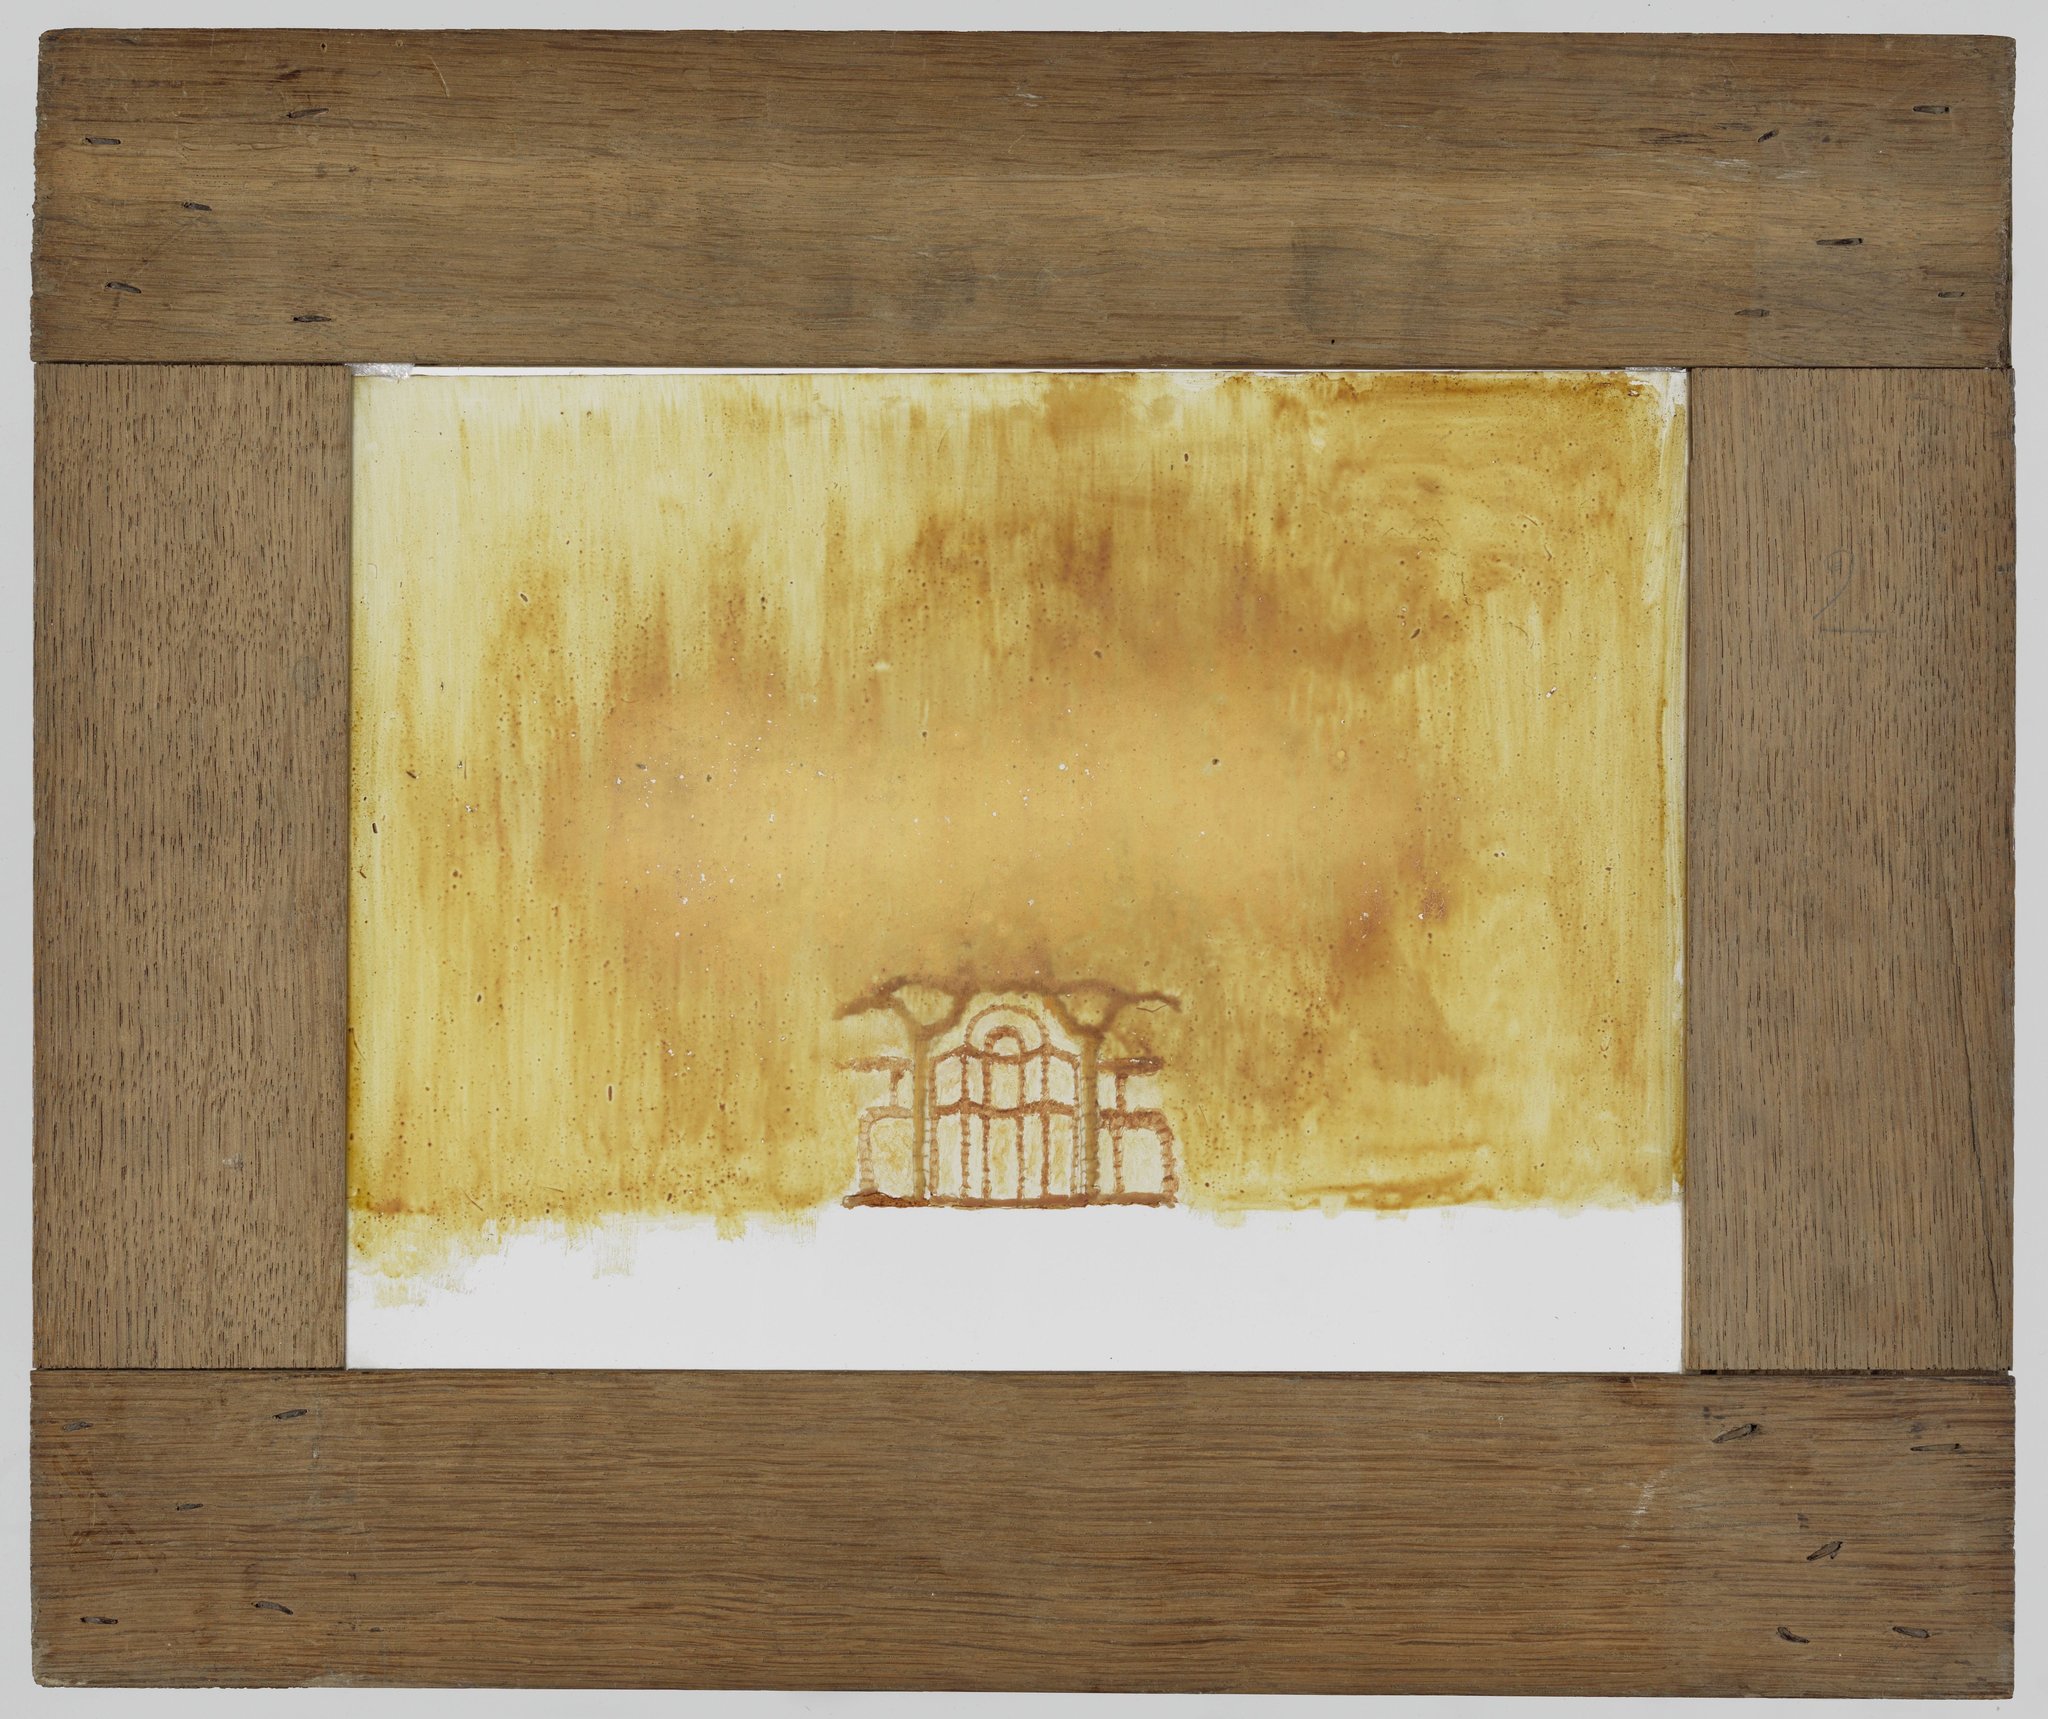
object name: diafanoramaplaat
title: Diafanorama van een hekwerk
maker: Anonymous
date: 1750-1830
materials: glass, wood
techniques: painted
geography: netherlands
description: Diafanorama van een soort hekwerk. De plaat is geel gekleurd. Onderkant is onbeschilderd.